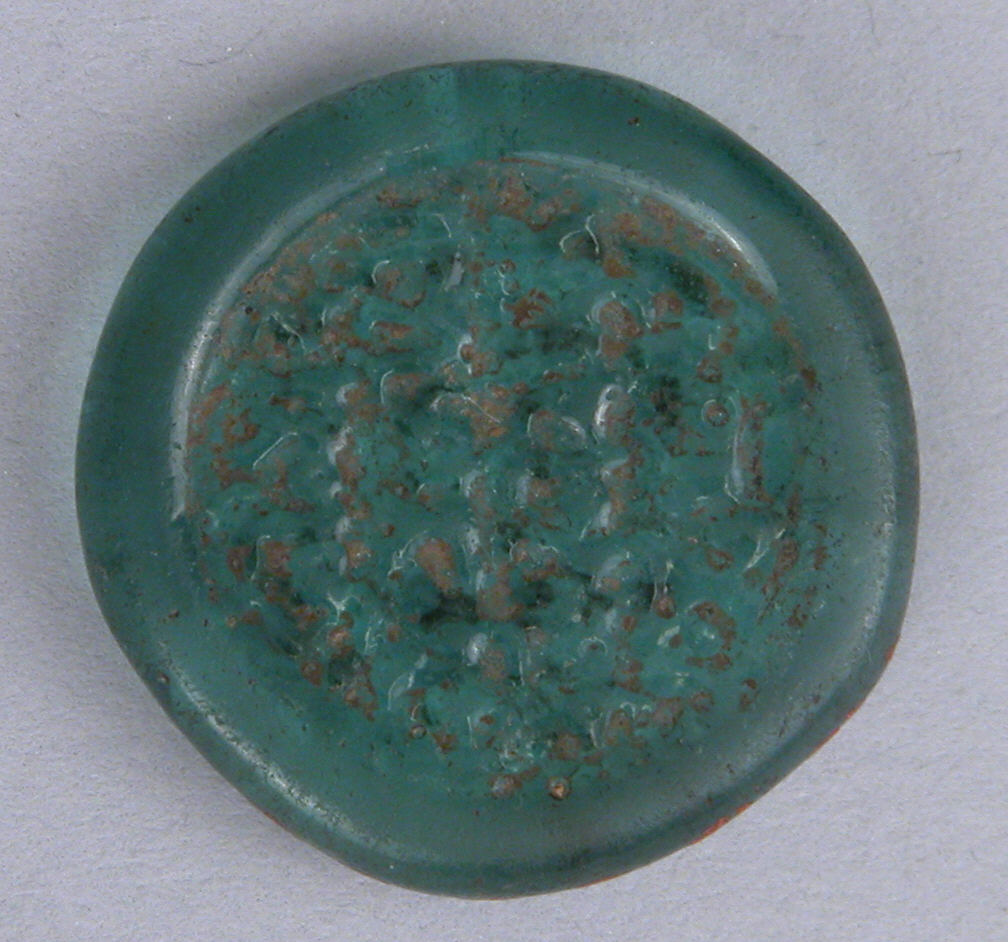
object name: coin weight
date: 1001-1100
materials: glass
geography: egypt